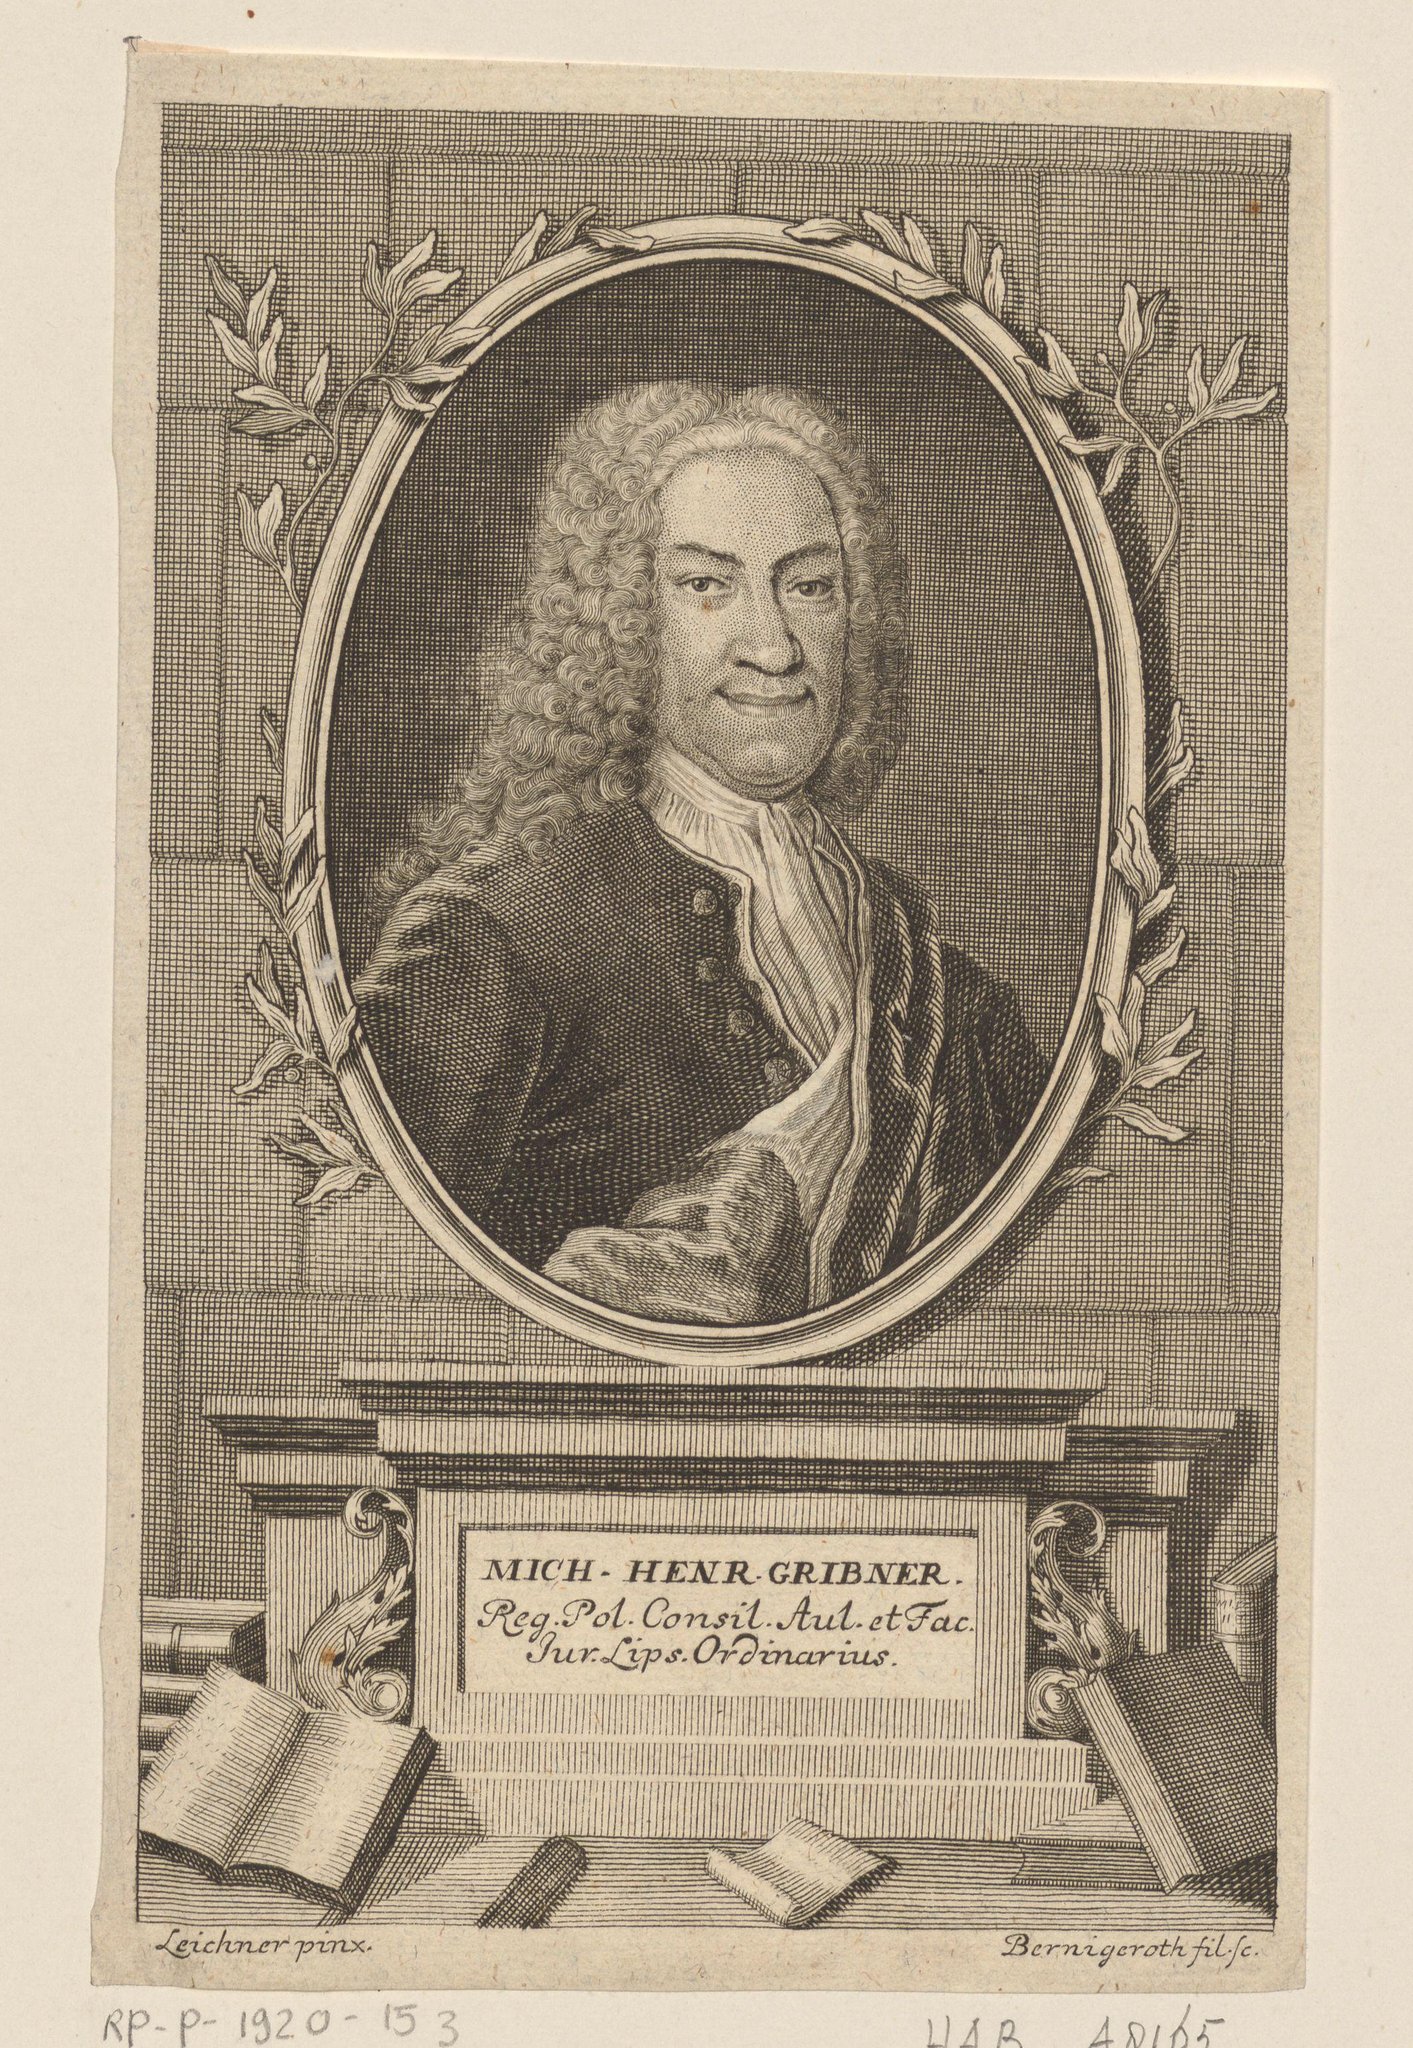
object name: book illustration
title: Portret van Michael Heinrich Griebner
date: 1735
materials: paper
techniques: engraving, etching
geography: leipzig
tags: historical persons, lawyer, attorney at law, professor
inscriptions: collector's mark: Lugt 2228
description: Prent uit: Deutsche Acta Eruditorum (...). Leipzig: Johann Gottlieb Gleditsch, 1735, dl. 189.